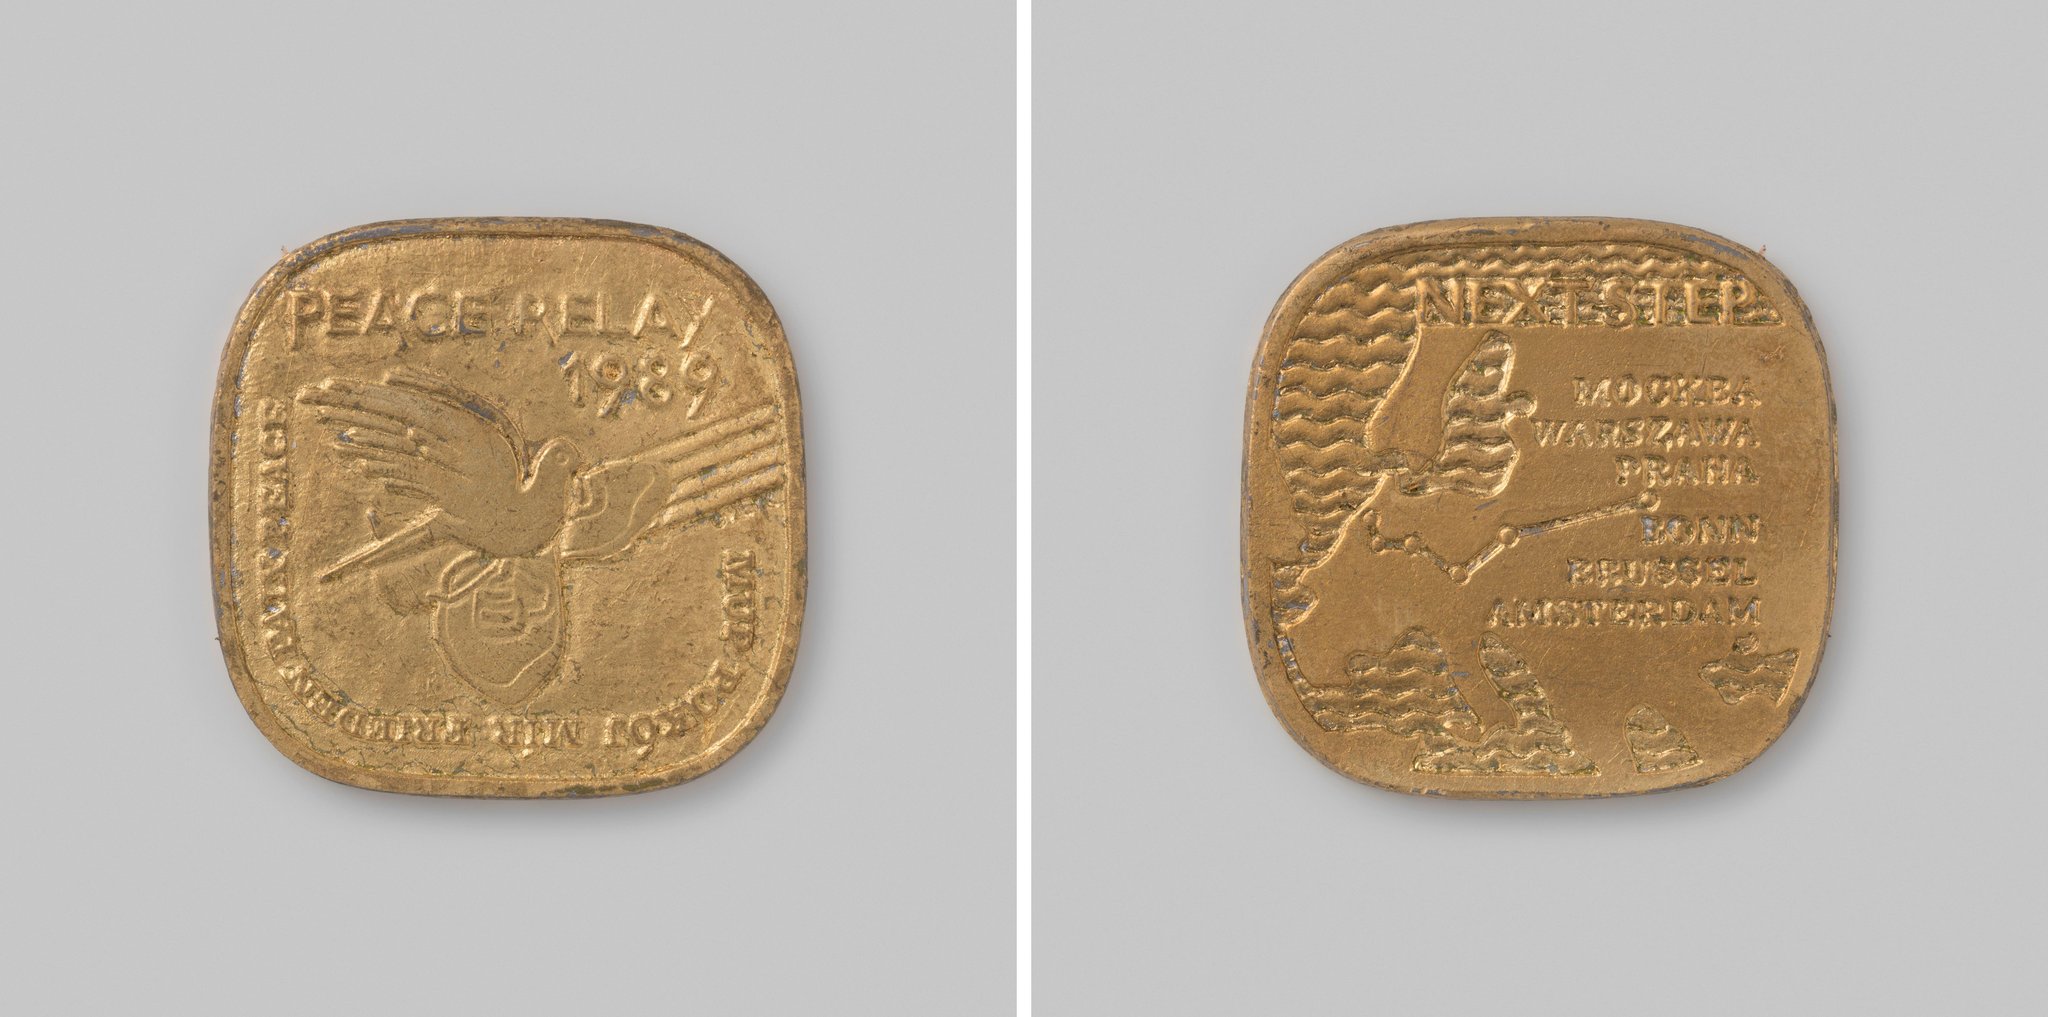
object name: history medal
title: Vredesestafette van Moskou naar Amsterdam, penning door deelnemers van tocht bij een bezoek aan het Rijksmuseum geschonken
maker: Anonymous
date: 1989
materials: alloy, paint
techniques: painting, striking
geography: soviet union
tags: brussels, prague, amsterdam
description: Vierkante penning met afgeronde hoeken. Voorzijde: vliegende duif boven drie onbekende objecten; rechts een schuine vierdelige balk onder opschrift binnen omschrift. Keerzijde: kaart van Europa met lijn die Moskou, Warschau, Praag, Bonn, Brussel en Amsterdam met elkaar verbindt onder opschrift.